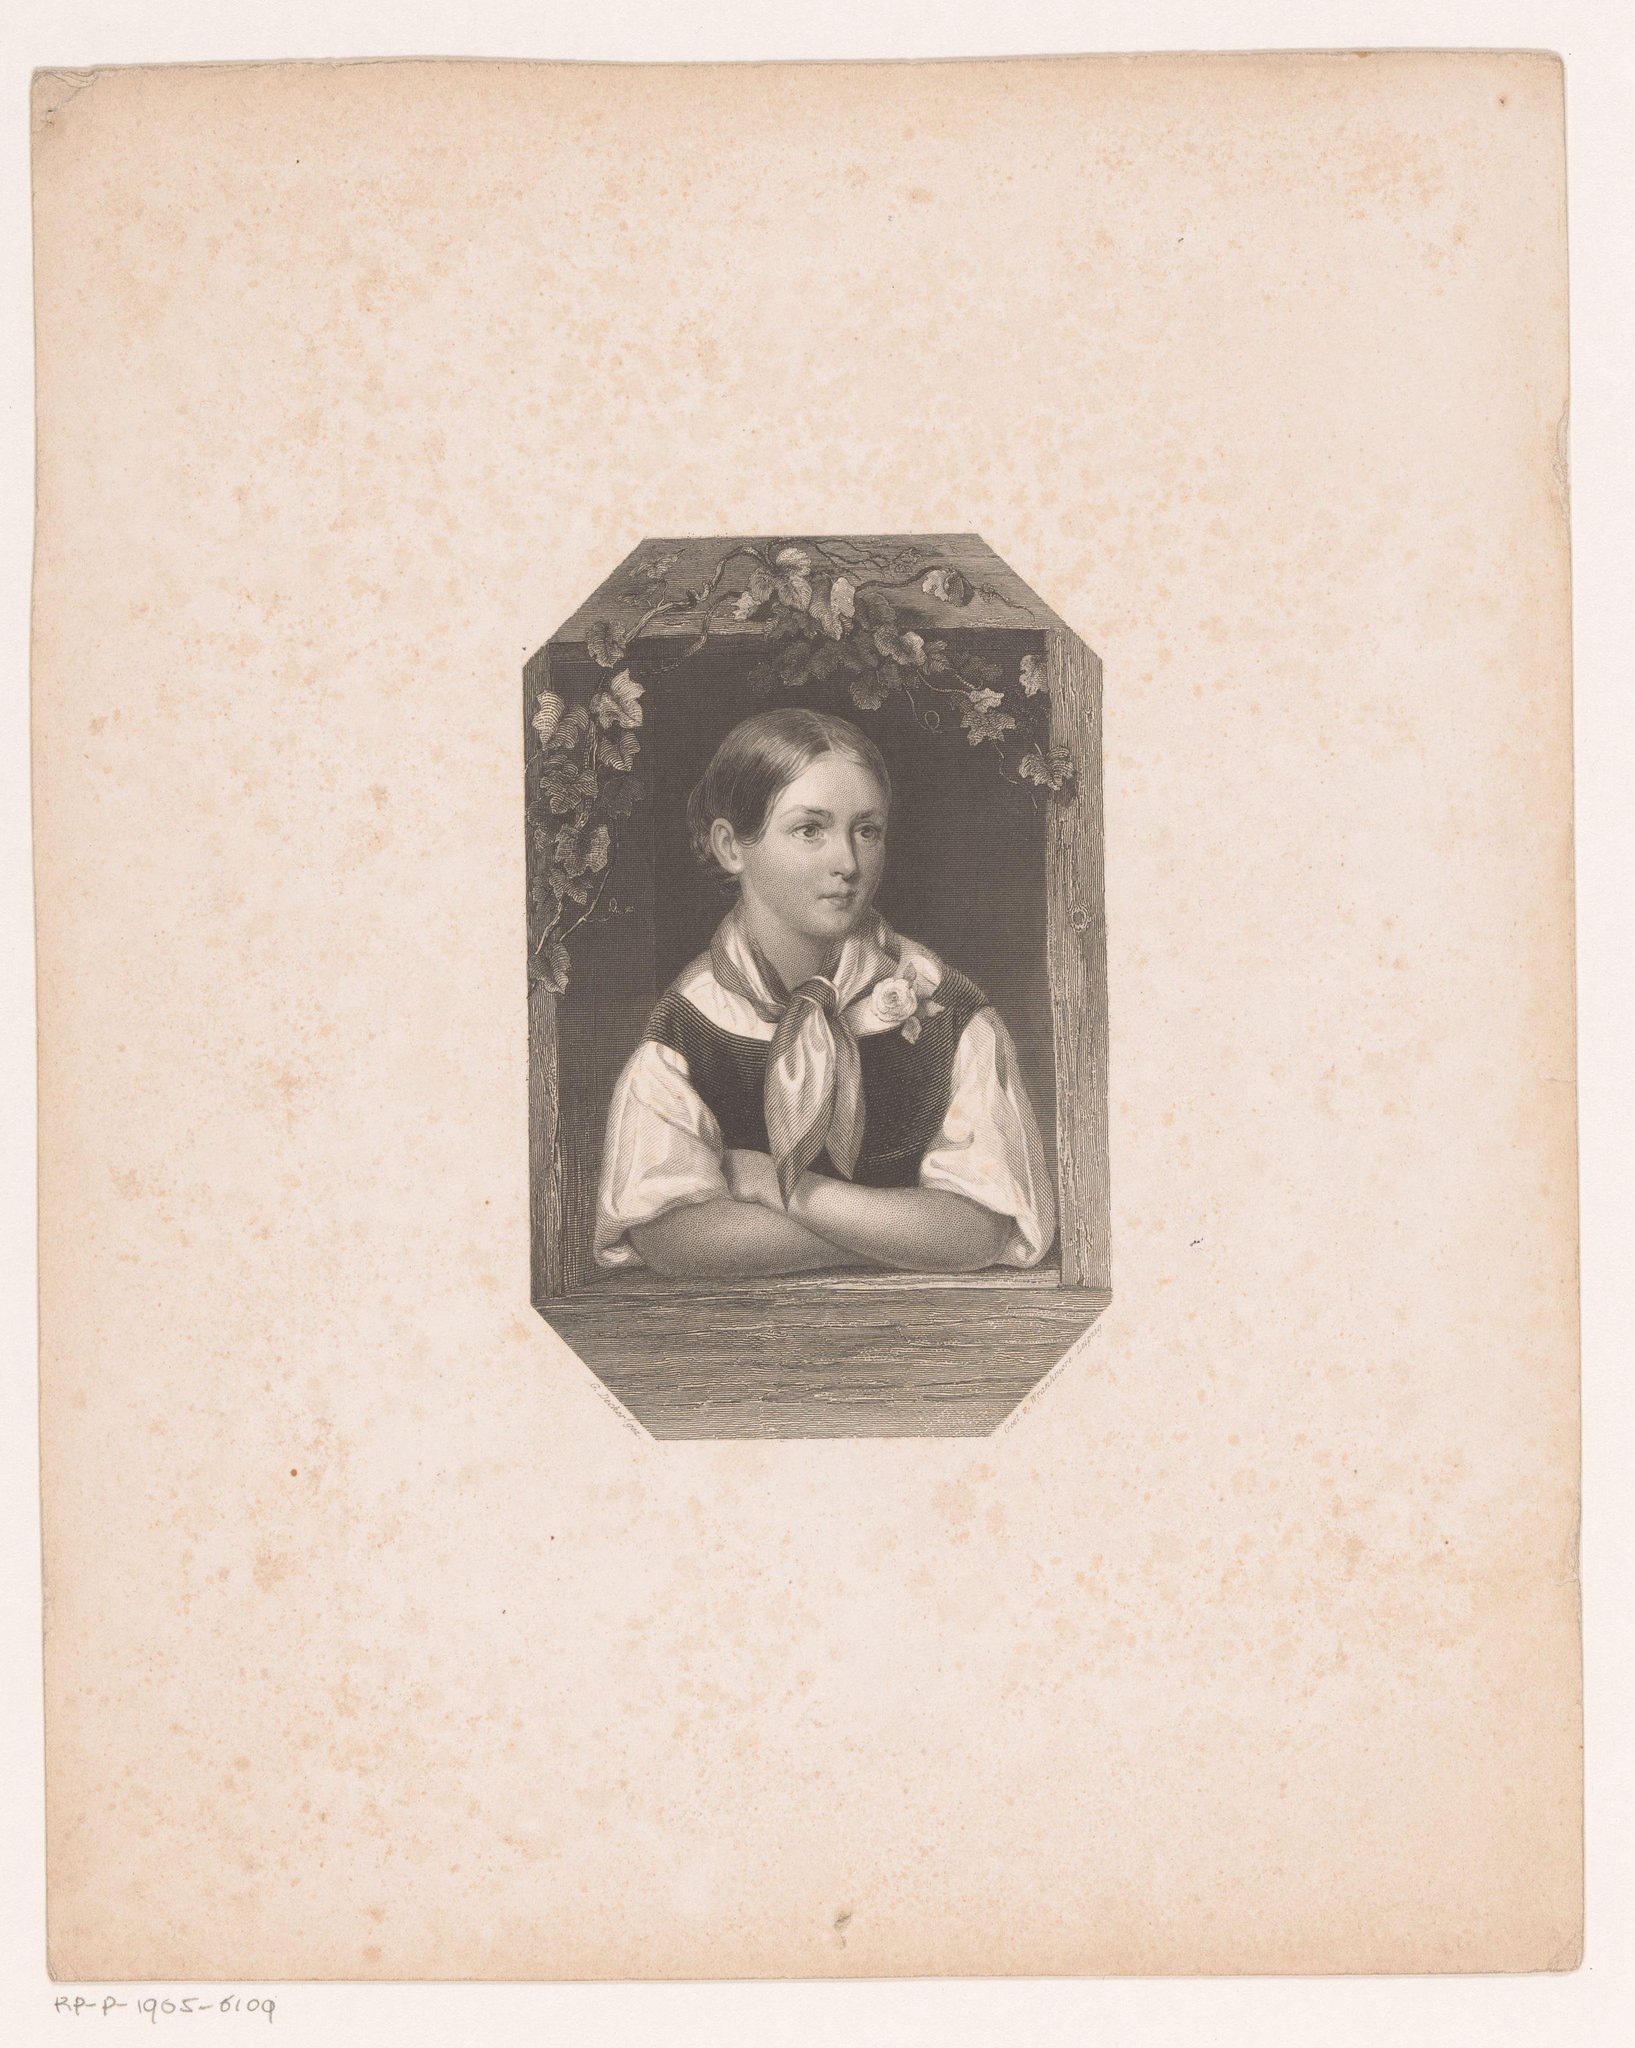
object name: print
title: Meisje in een raamkozijn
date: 1826-1840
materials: paper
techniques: etching, engraving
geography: leipzig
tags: girl (child between toddler and youth)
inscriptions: collector's mark: Lugt 2228